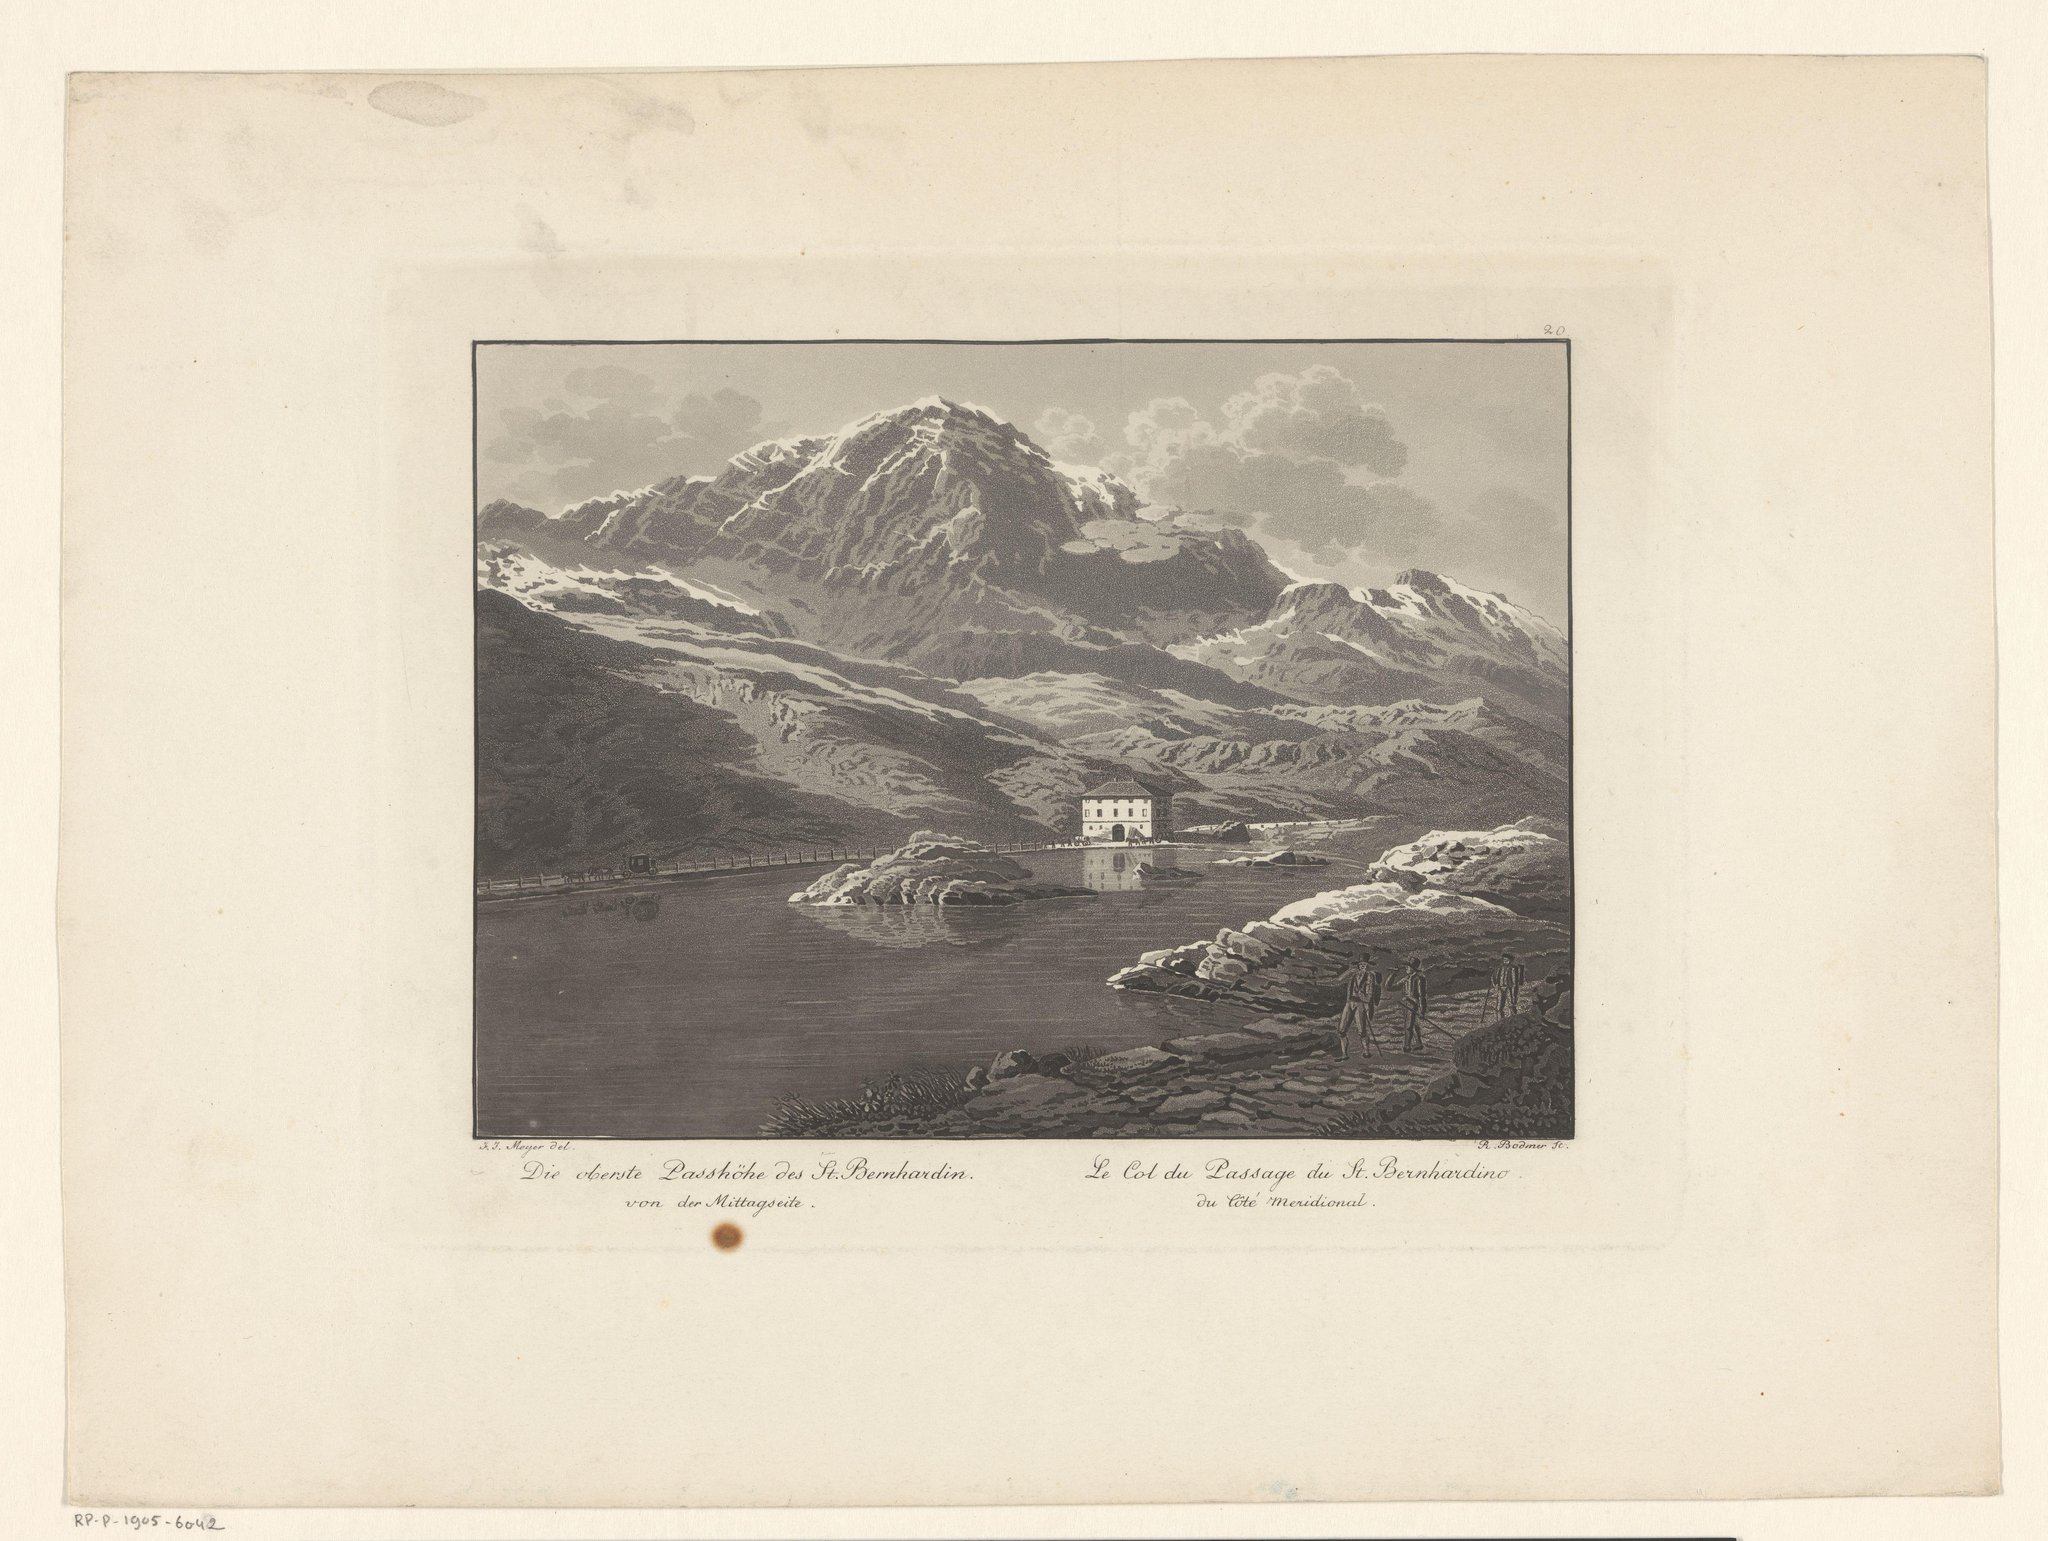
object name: print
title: Reis door Graubünden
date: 1826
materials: paper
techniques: aquatint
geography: zurich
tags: walking, hiking (recreation), mountains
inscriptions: collector's mark: Lugt 2228